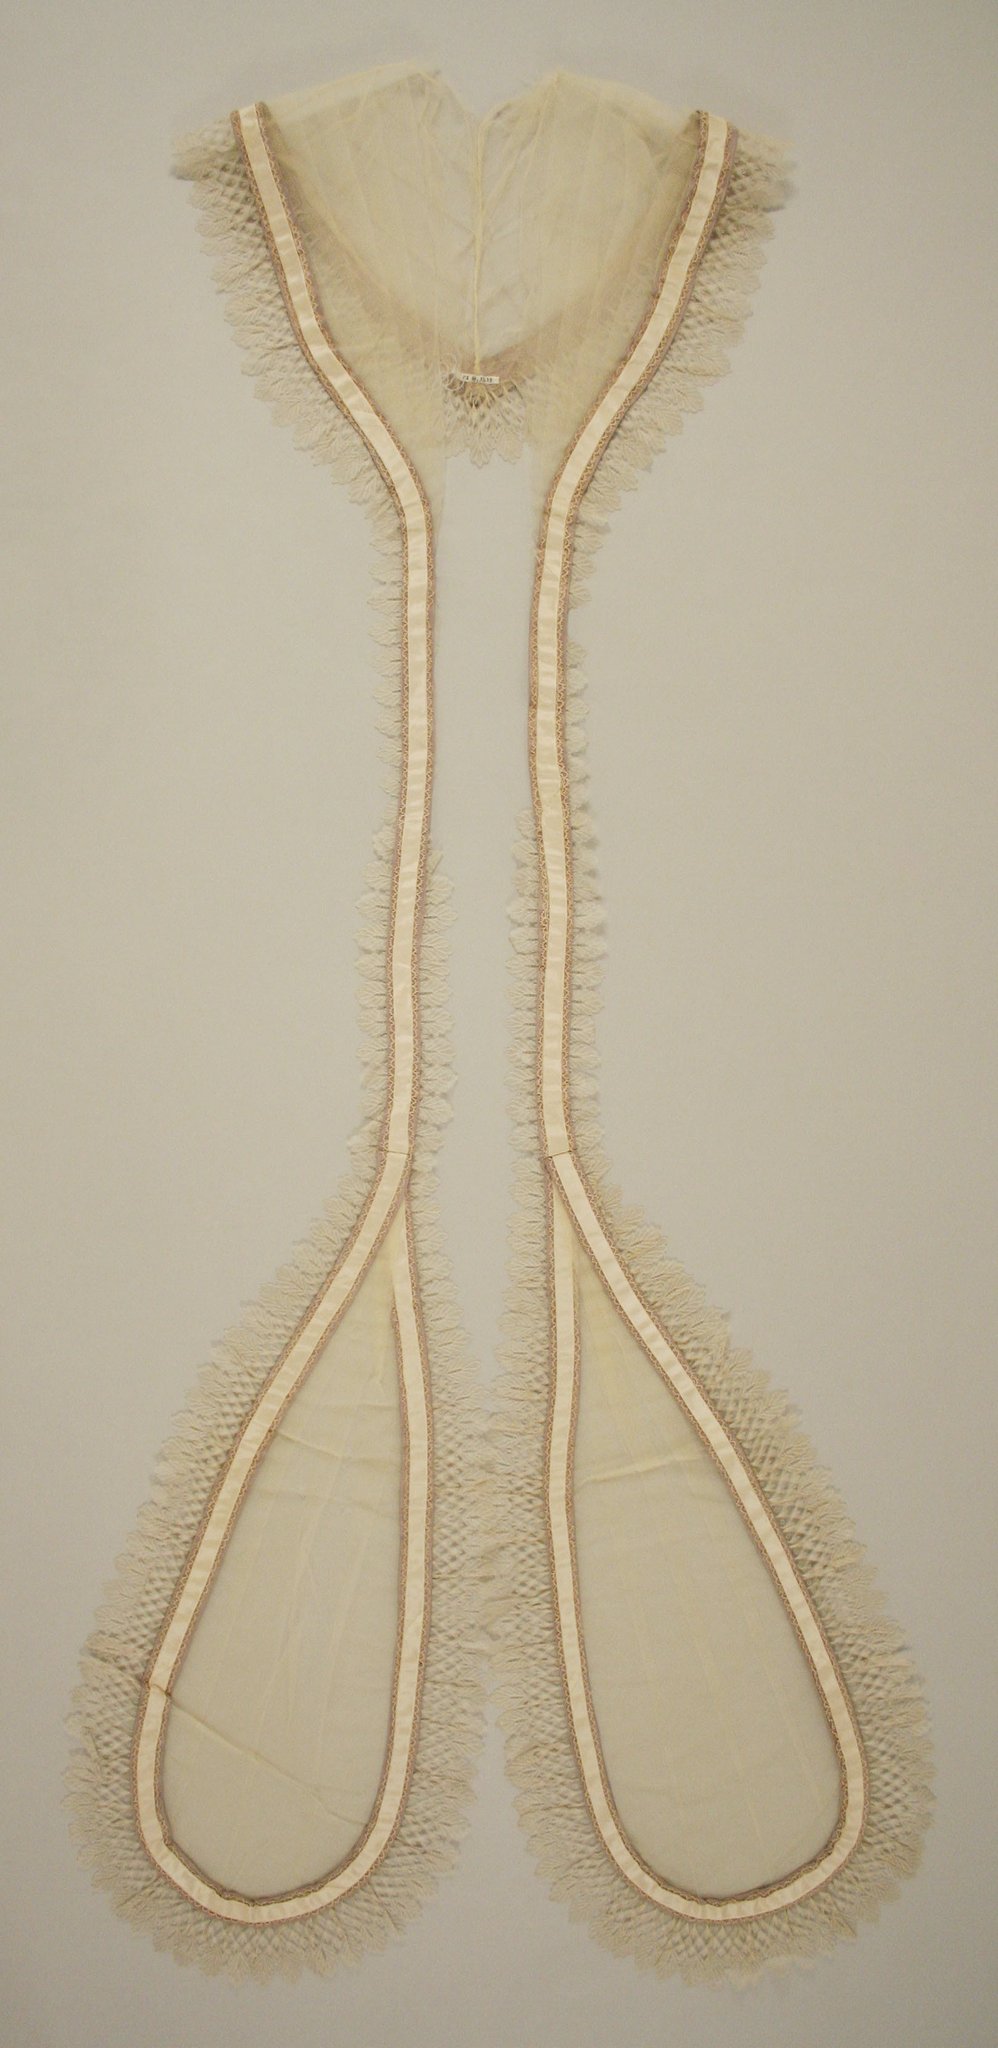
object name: fichu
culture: american or european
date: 1834-1866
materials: silk